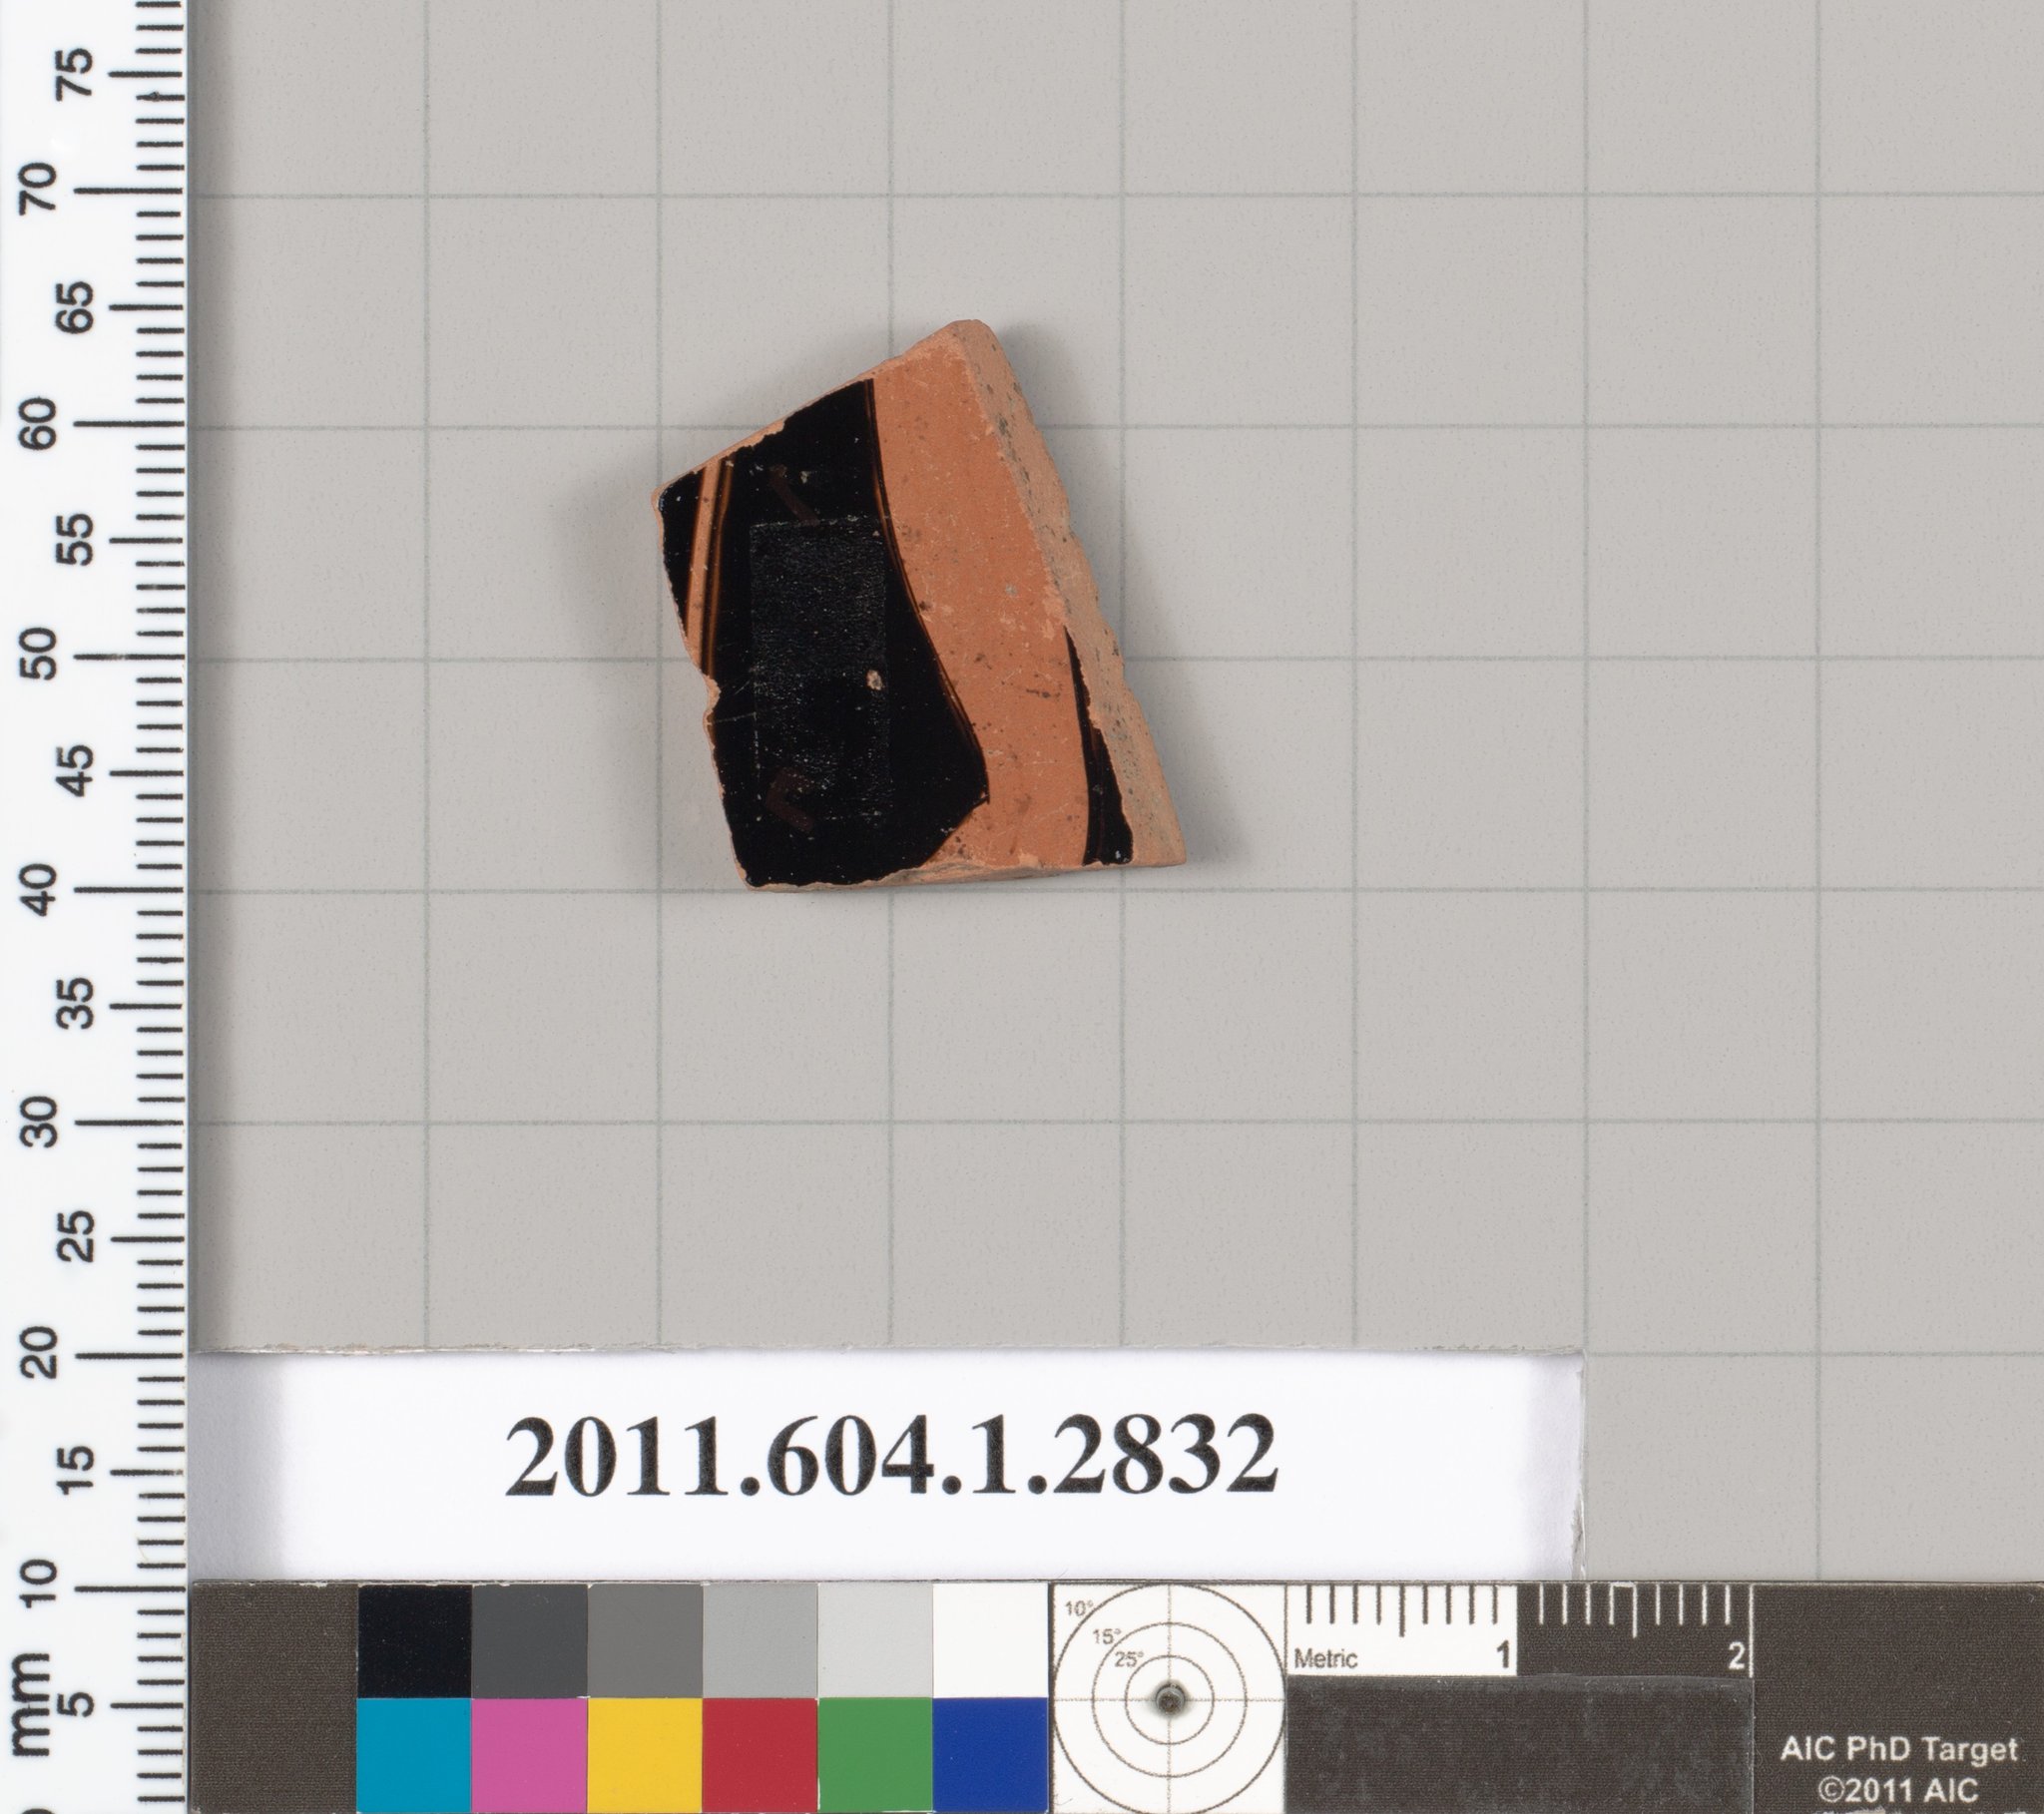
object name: kylix fragment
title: Terracotta fragment of a kylix (drinking cup)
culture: greek, attic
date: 520-500 BCE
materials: terracotta